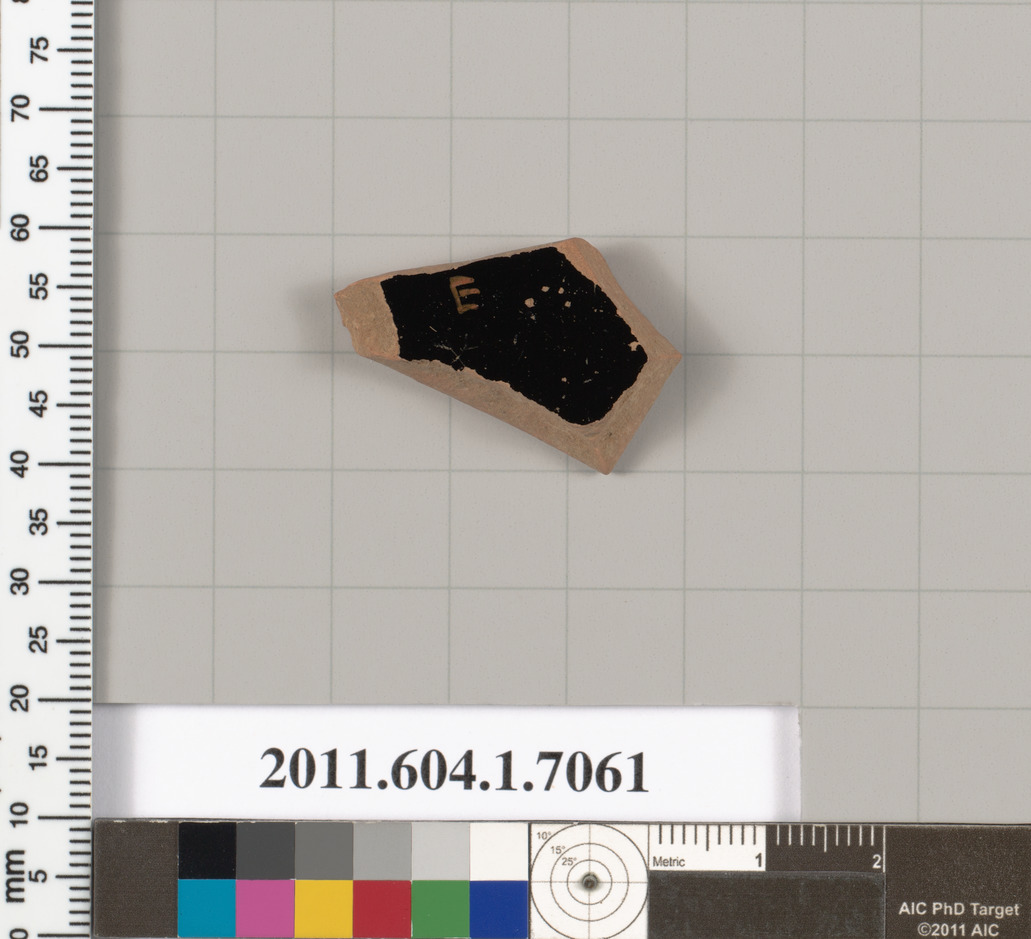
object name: kylix fragment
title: Terracotta fragment of a kylix (drinking cup)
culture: greek, attic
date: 500-480 BCE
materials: terracotta